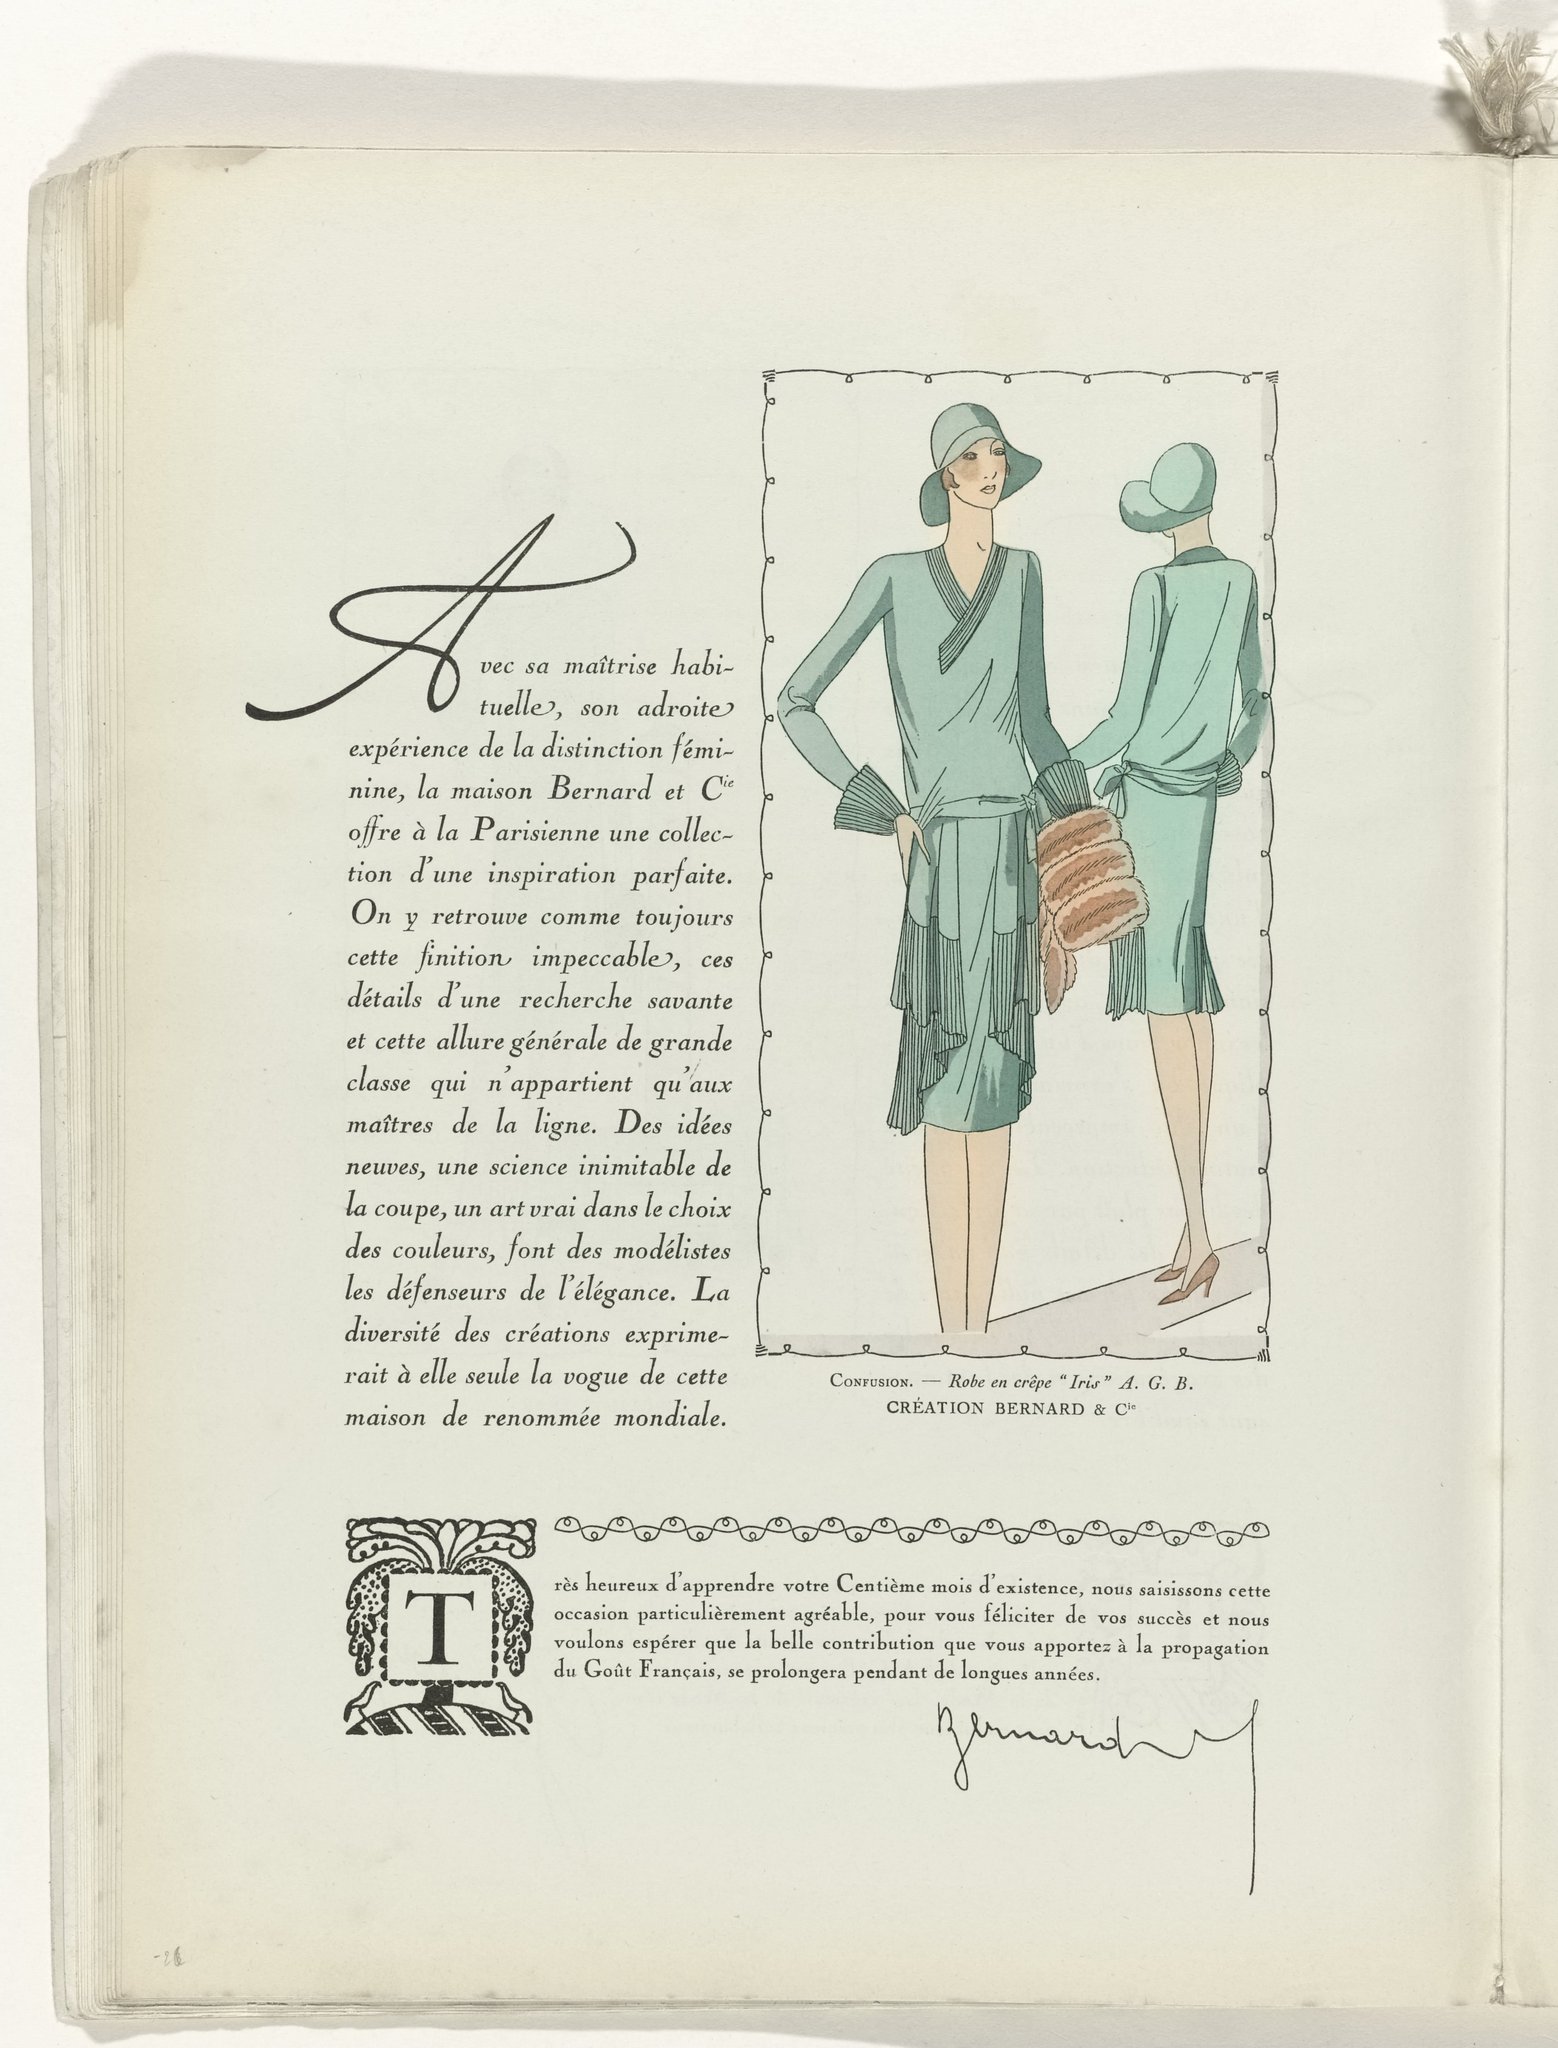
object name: fashion print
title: Art - Goût - Beauté, Feuillets de l' élégance féminine, Noël 1928, No. 100, 9e Année, p. 26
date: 1928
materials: paper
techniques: hand coloring, lithograph, pochoir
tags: fashion plates, head-gear: hat (+ women's clothes), dress, gown (+ women's clothes), muff (+ fur used for clothes)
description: Tekst met een afbeelding van een vrouw in een groene jurk van 'crêpe "iris"A.G.B., van Bernard & Cie. Mof van bont in de hand. Pagina uit het modetijdschrift Art-Goût-Beauté (1920-1933).